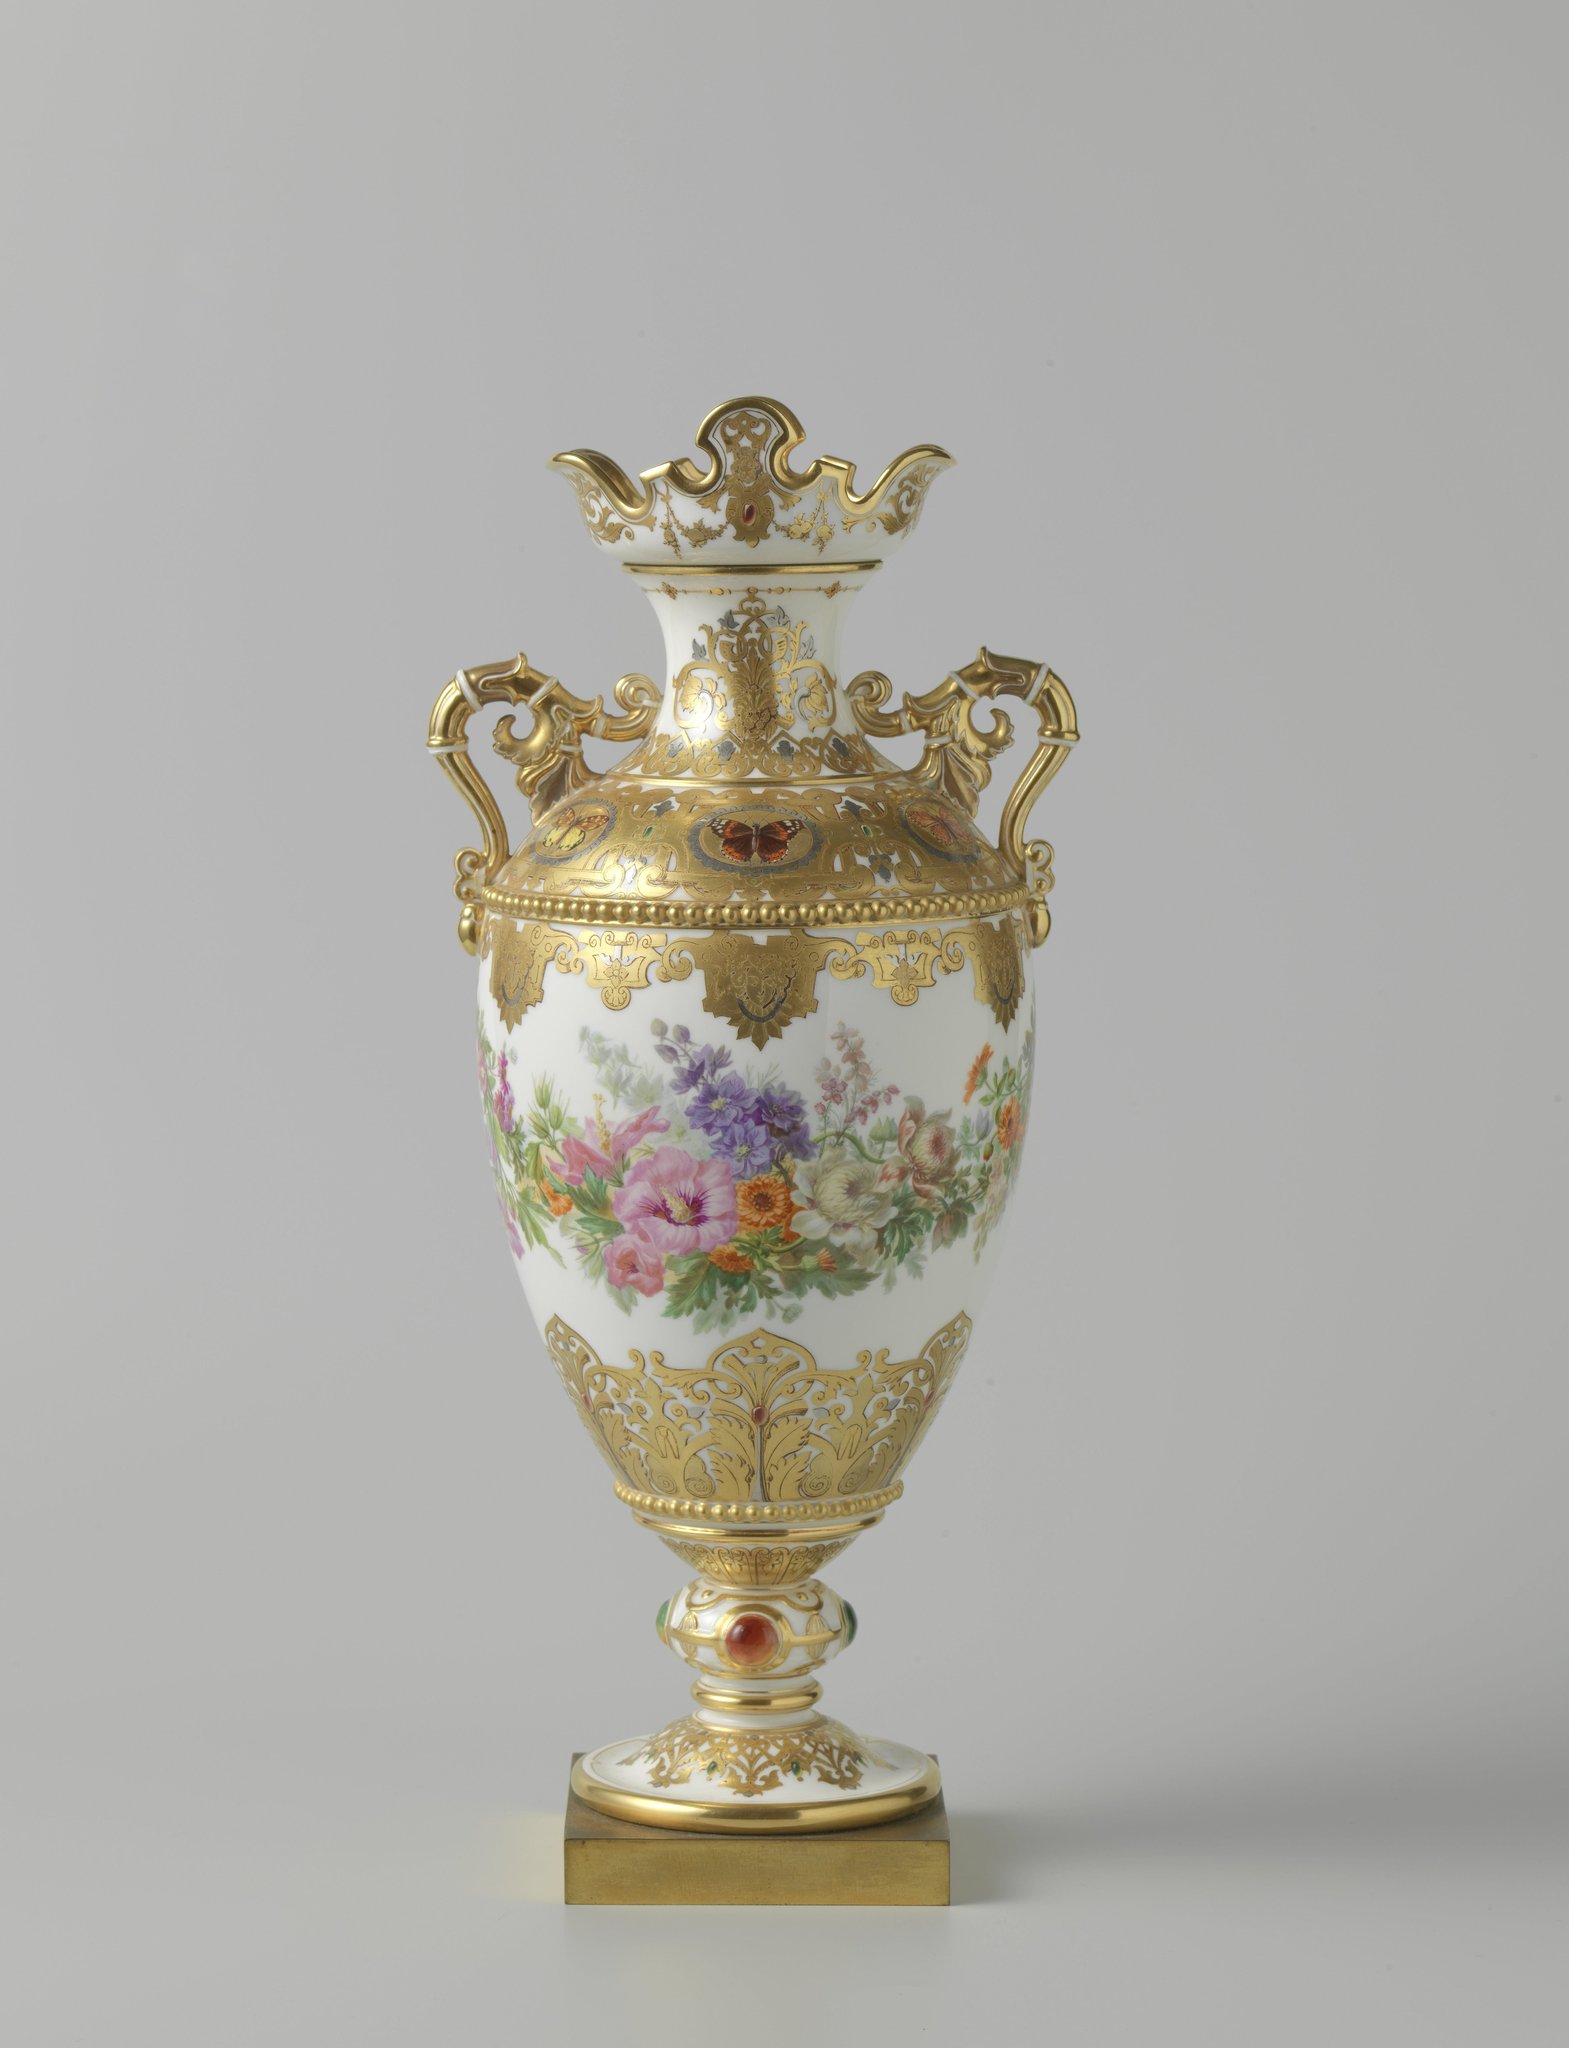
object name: vase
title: Pair of vases (Vases Adélaïde)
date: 1848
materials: bronze, gold, platinum, porcelain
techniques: gilding, painted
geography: sèvres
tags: flowers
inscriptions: mark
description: Vaas van porselein met hoog aangezette, kleine, in een bladkrul eindigende oren, op vierkante vergulde sokkel, beschilderd in goud en platina met renaissance-achtige ornamentranden met veelkleurige vlinders en driedimensionale "stenen", tussen de randen een brede wit gelaten zône waarop veelkleurige bloemslingers.